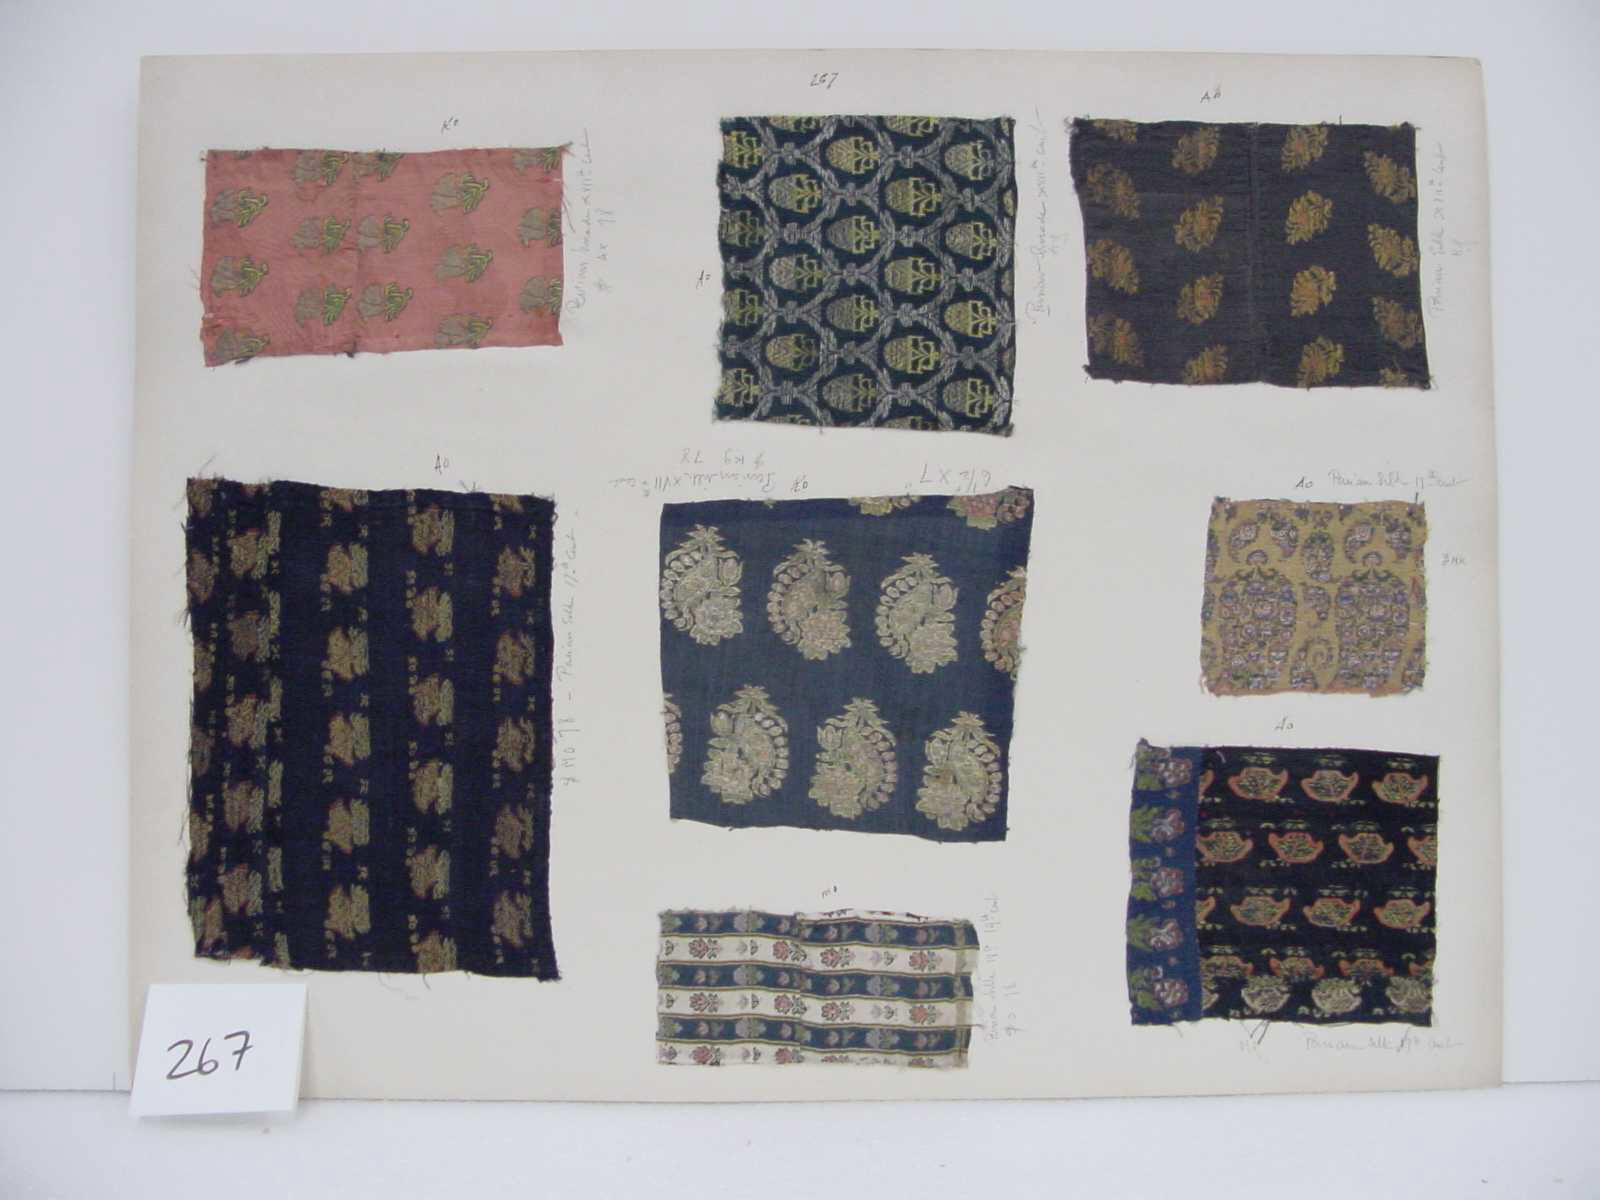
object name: textile fragment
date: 1601-1800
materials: silk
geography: iran